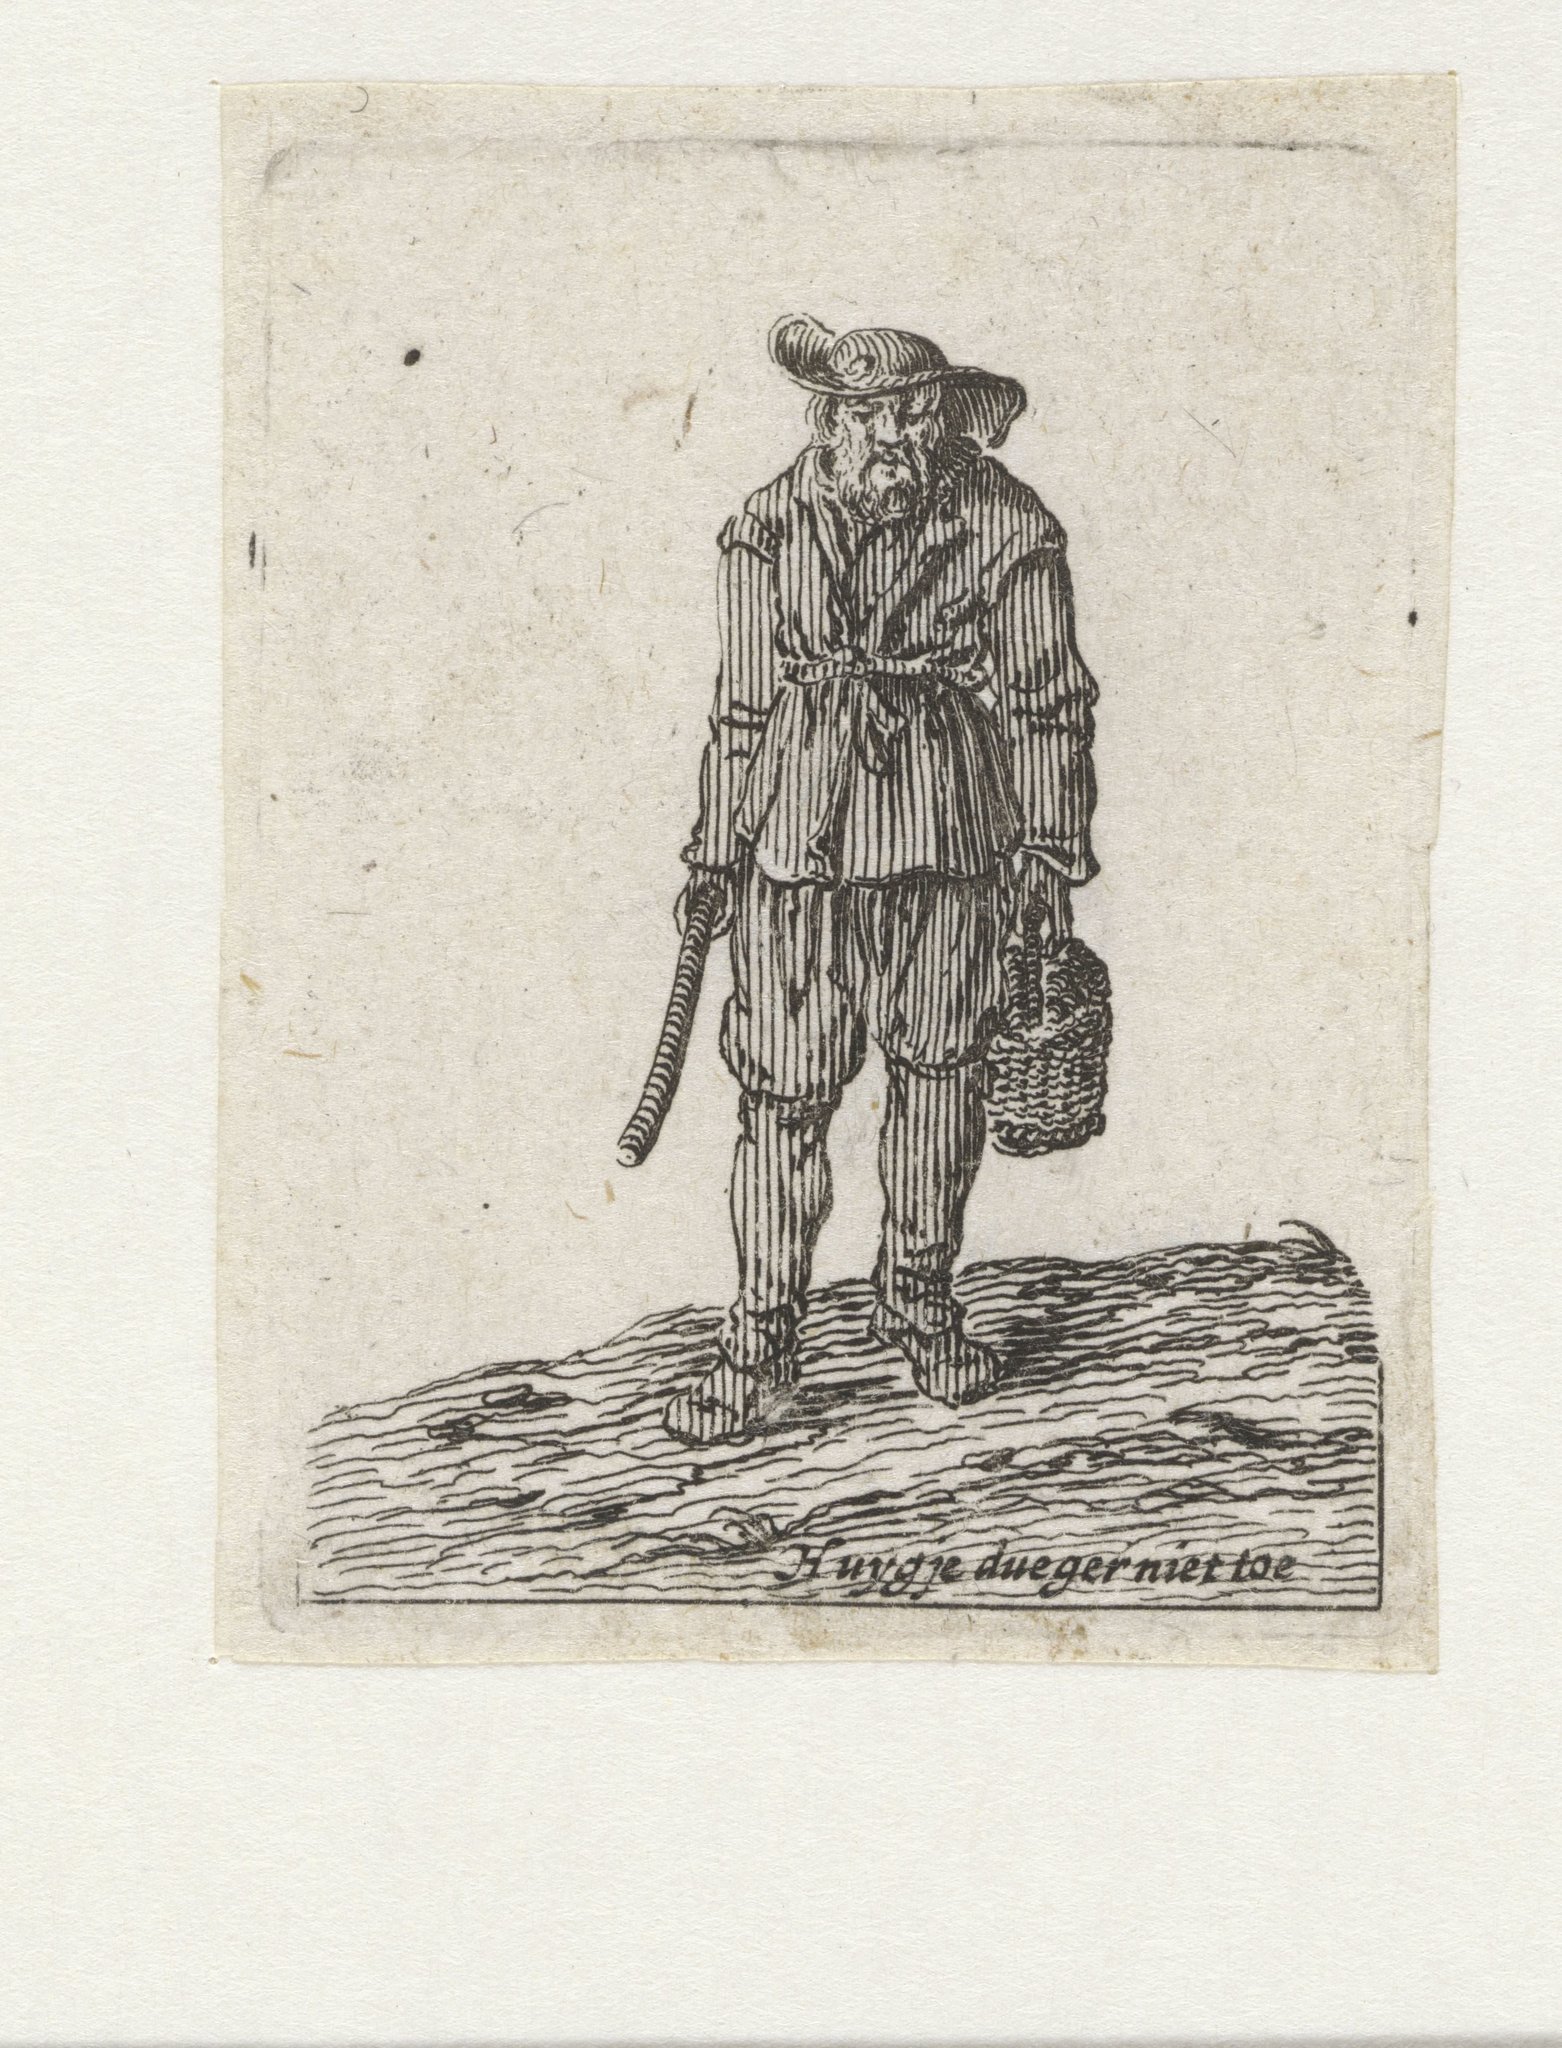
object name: print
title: Man met stok en mand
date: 1638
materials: paper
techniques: etching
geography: netherlands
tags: head-gear: hat (+ men's clothes)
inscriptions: collector's mark: Lugt 2228, collector's mark: Lugt 2760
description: Een man met een hoed op het hoofd en in de handen een mand en een stok. De prent maakt deel uit van een serie van 32 prenten met genretaferelen.